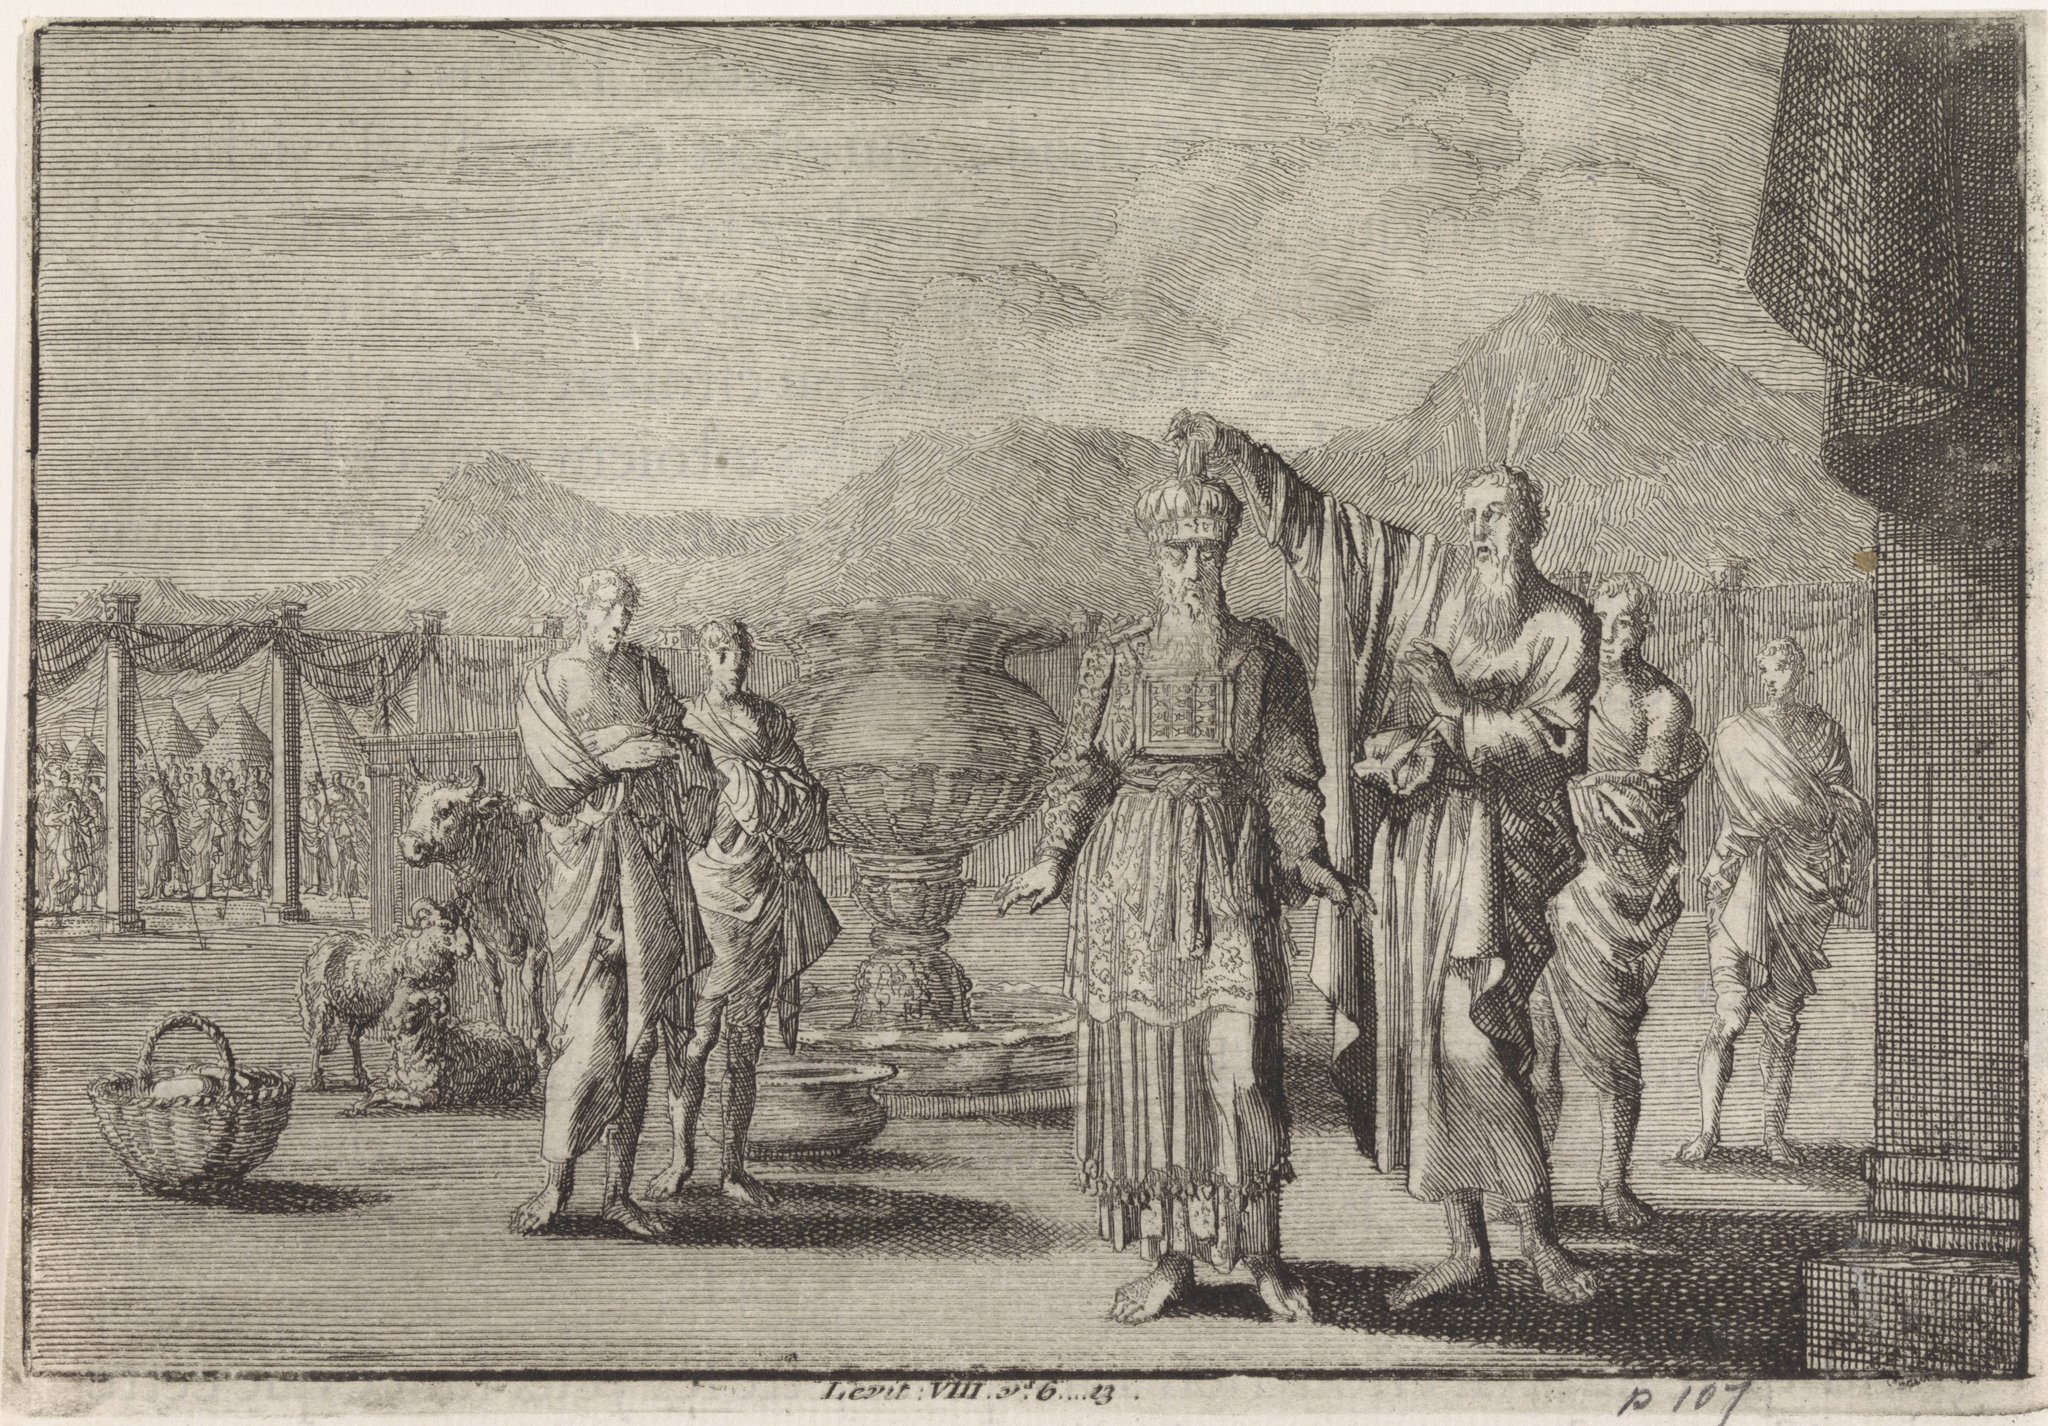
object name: book illustration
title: Aäron en zijn vier zonen als priester gewijd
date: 1703-1762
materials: paper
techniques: etching, letterpress printing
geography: haarlem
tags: aaron and his four sons are ordained by moses (leviticus 8)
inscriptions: collector's mark: Lugt 2228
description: De prent komt een eerste keer voor als boekillustratie voor David Martin. Historie des Ouden en Nieuwen Testaments. Amsterdam, Pieter Mortier, 1703. Deel I. De boekillustraties voor de Mortierbijbel hebben verschillende staten en kopieën, waarbij de chronologische volgorde moeilijk te achterhalen valt. Als boekillustraties werden ze bovendien herhaaldelijk opnieuw gebruikt voor andere boekwerken.